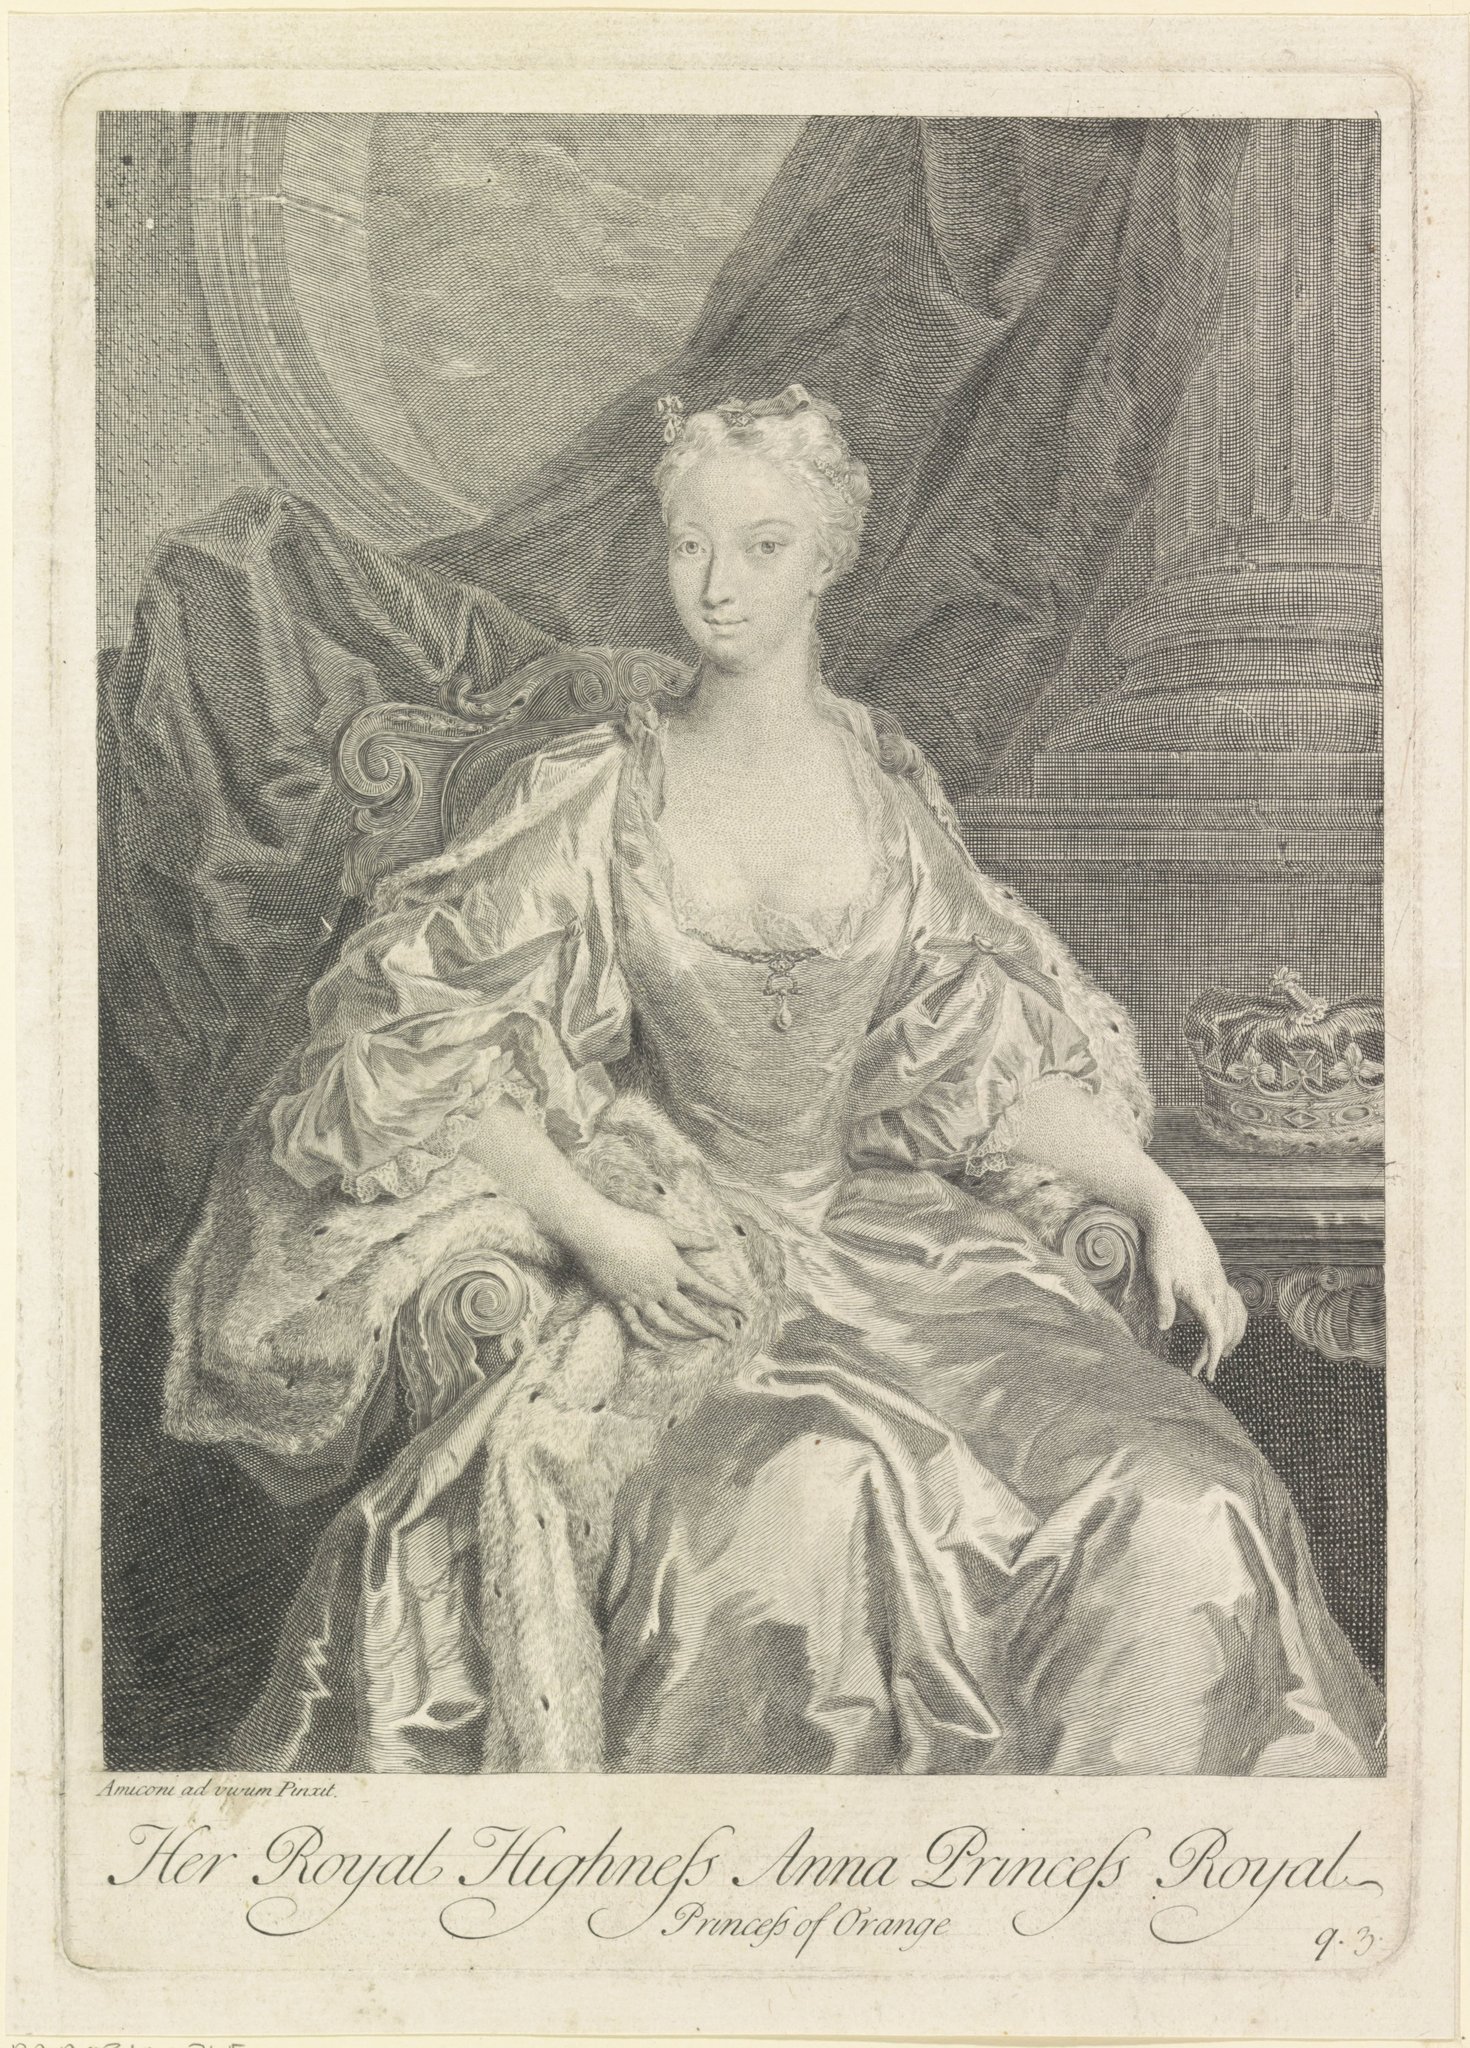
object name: print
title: Portret van Anna van Hannover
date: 1734-1799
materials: paper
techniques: engraving, etching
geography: low countries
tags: the hague, anna van hannover